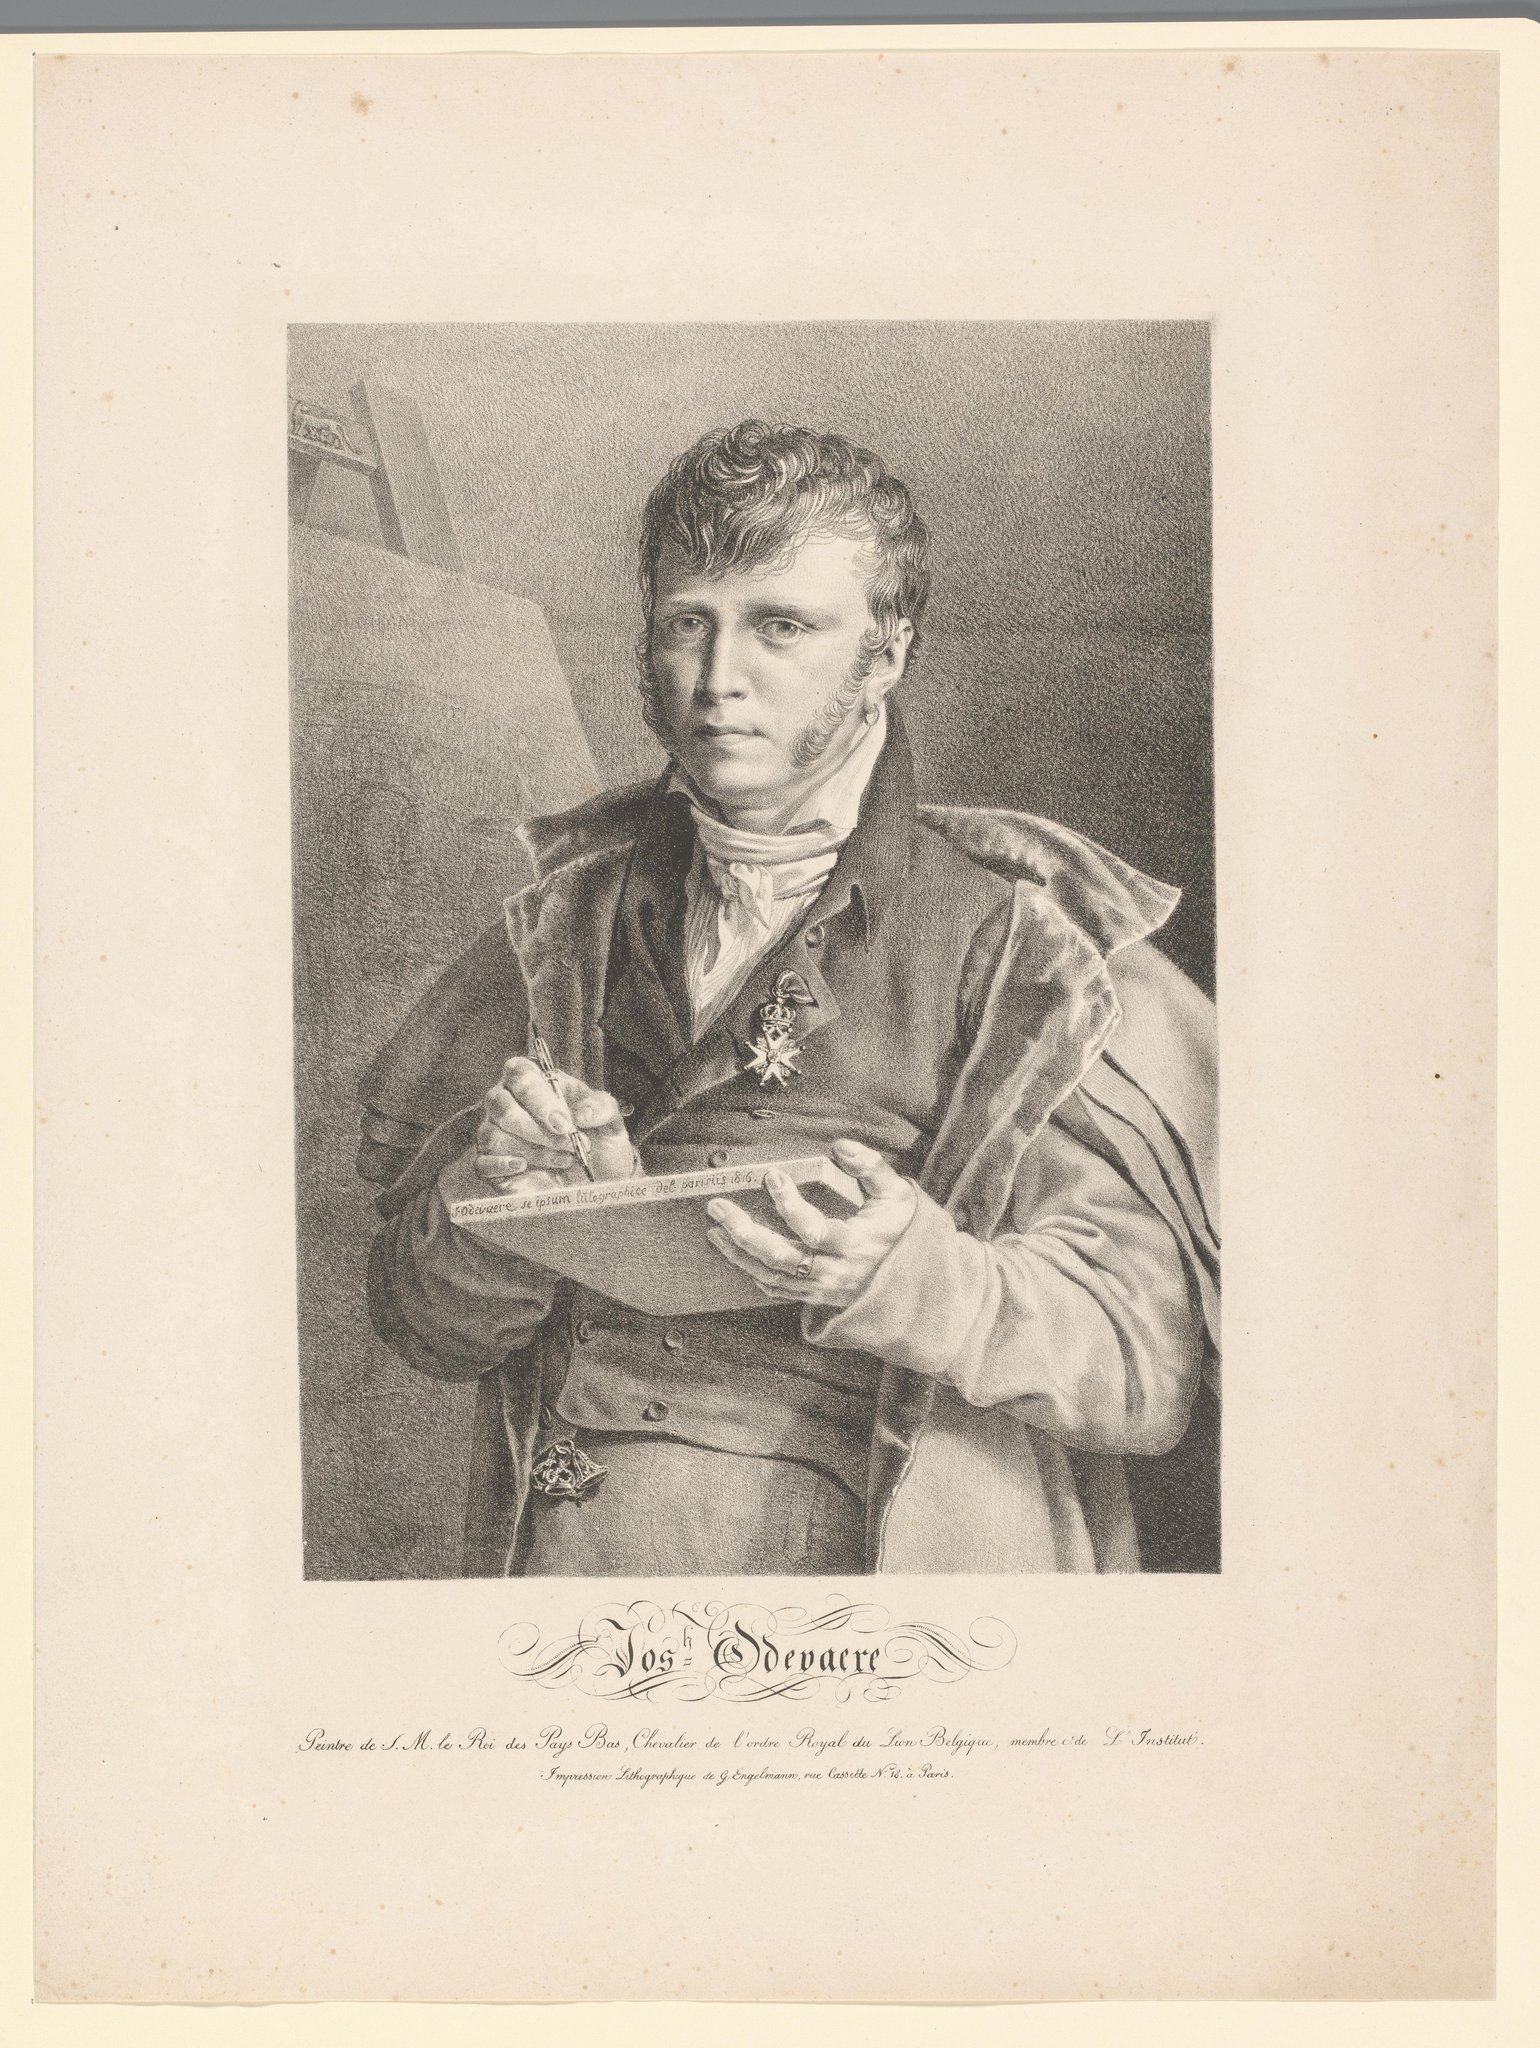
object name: print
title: Josh. Odevaere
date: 1816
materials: paper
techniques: lithograph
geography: paris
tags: bruges, brussels, painter, print maker, joseph-denis odevaere, historical persons, portrait, self-portrait of graphic artist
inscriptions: collector's mark: Lugt 2228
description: Odevaere draagt de Orde van de Nederlandse Leeuw.